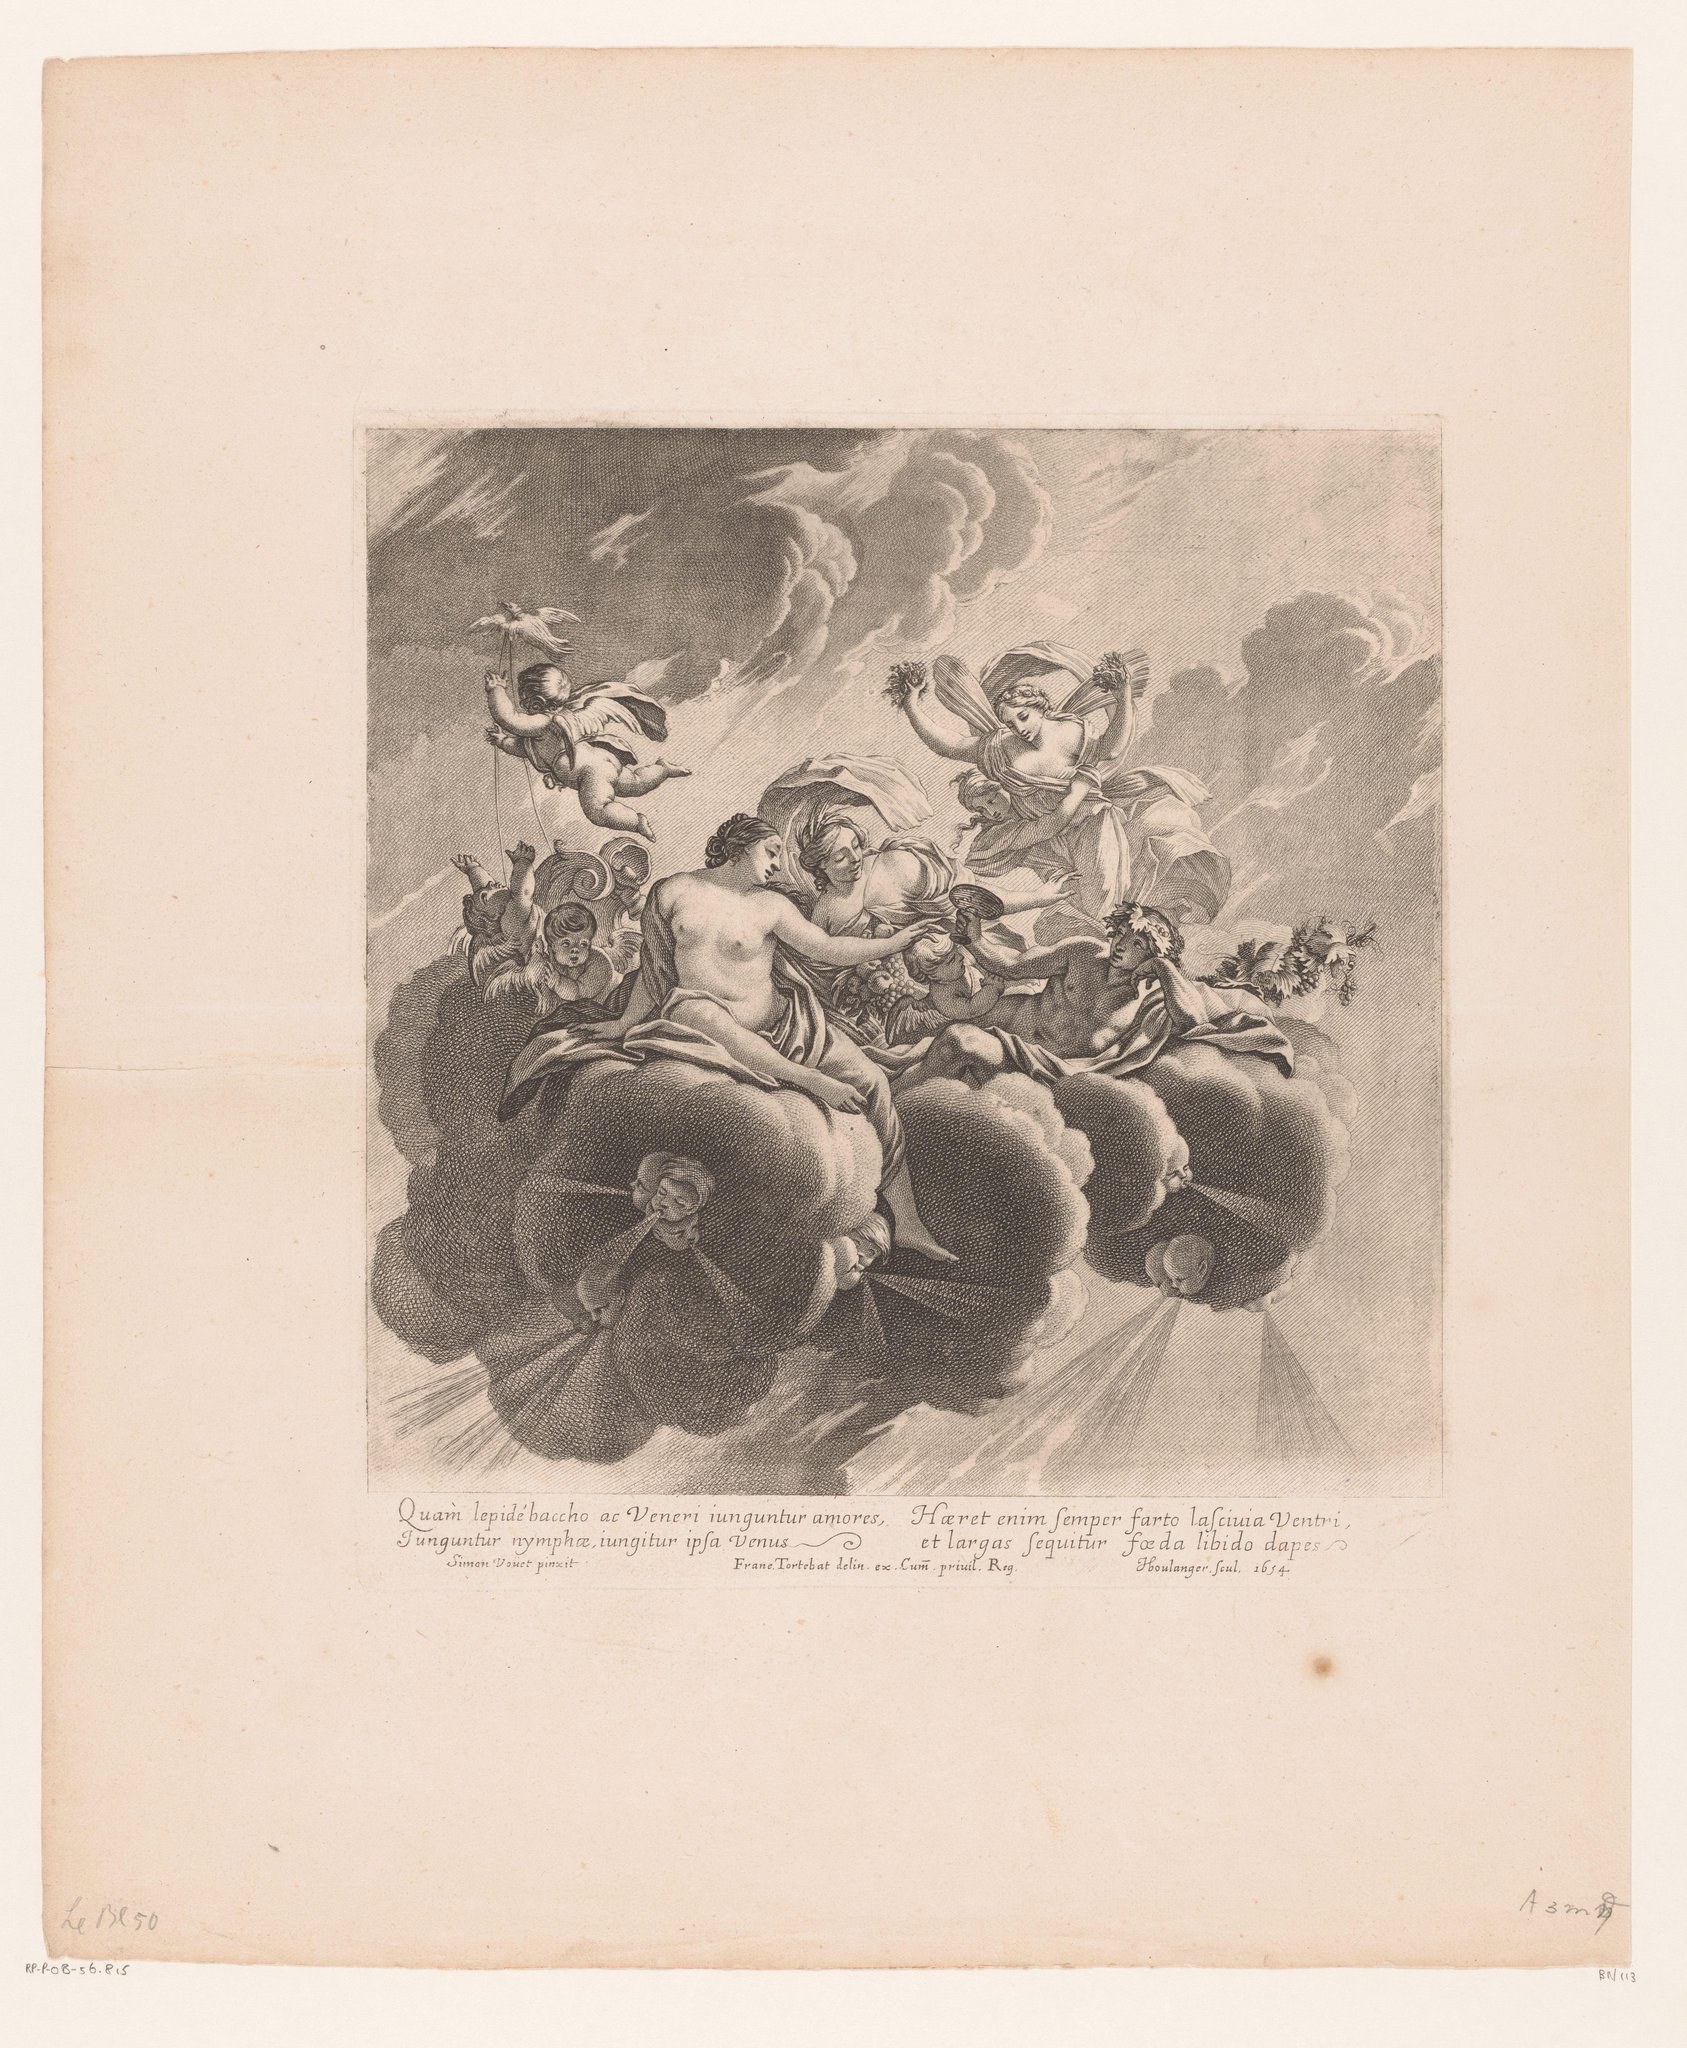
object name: print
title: Venus, Bacchus en Ceres bijeengekomen op een wolk (Sine Cerere et Baccho friget Venus)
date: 1654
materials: paper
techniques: engraving, etching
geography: france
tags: 'sine cerere et baccho friget venus'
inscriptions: collector's mark: Lugt 2228